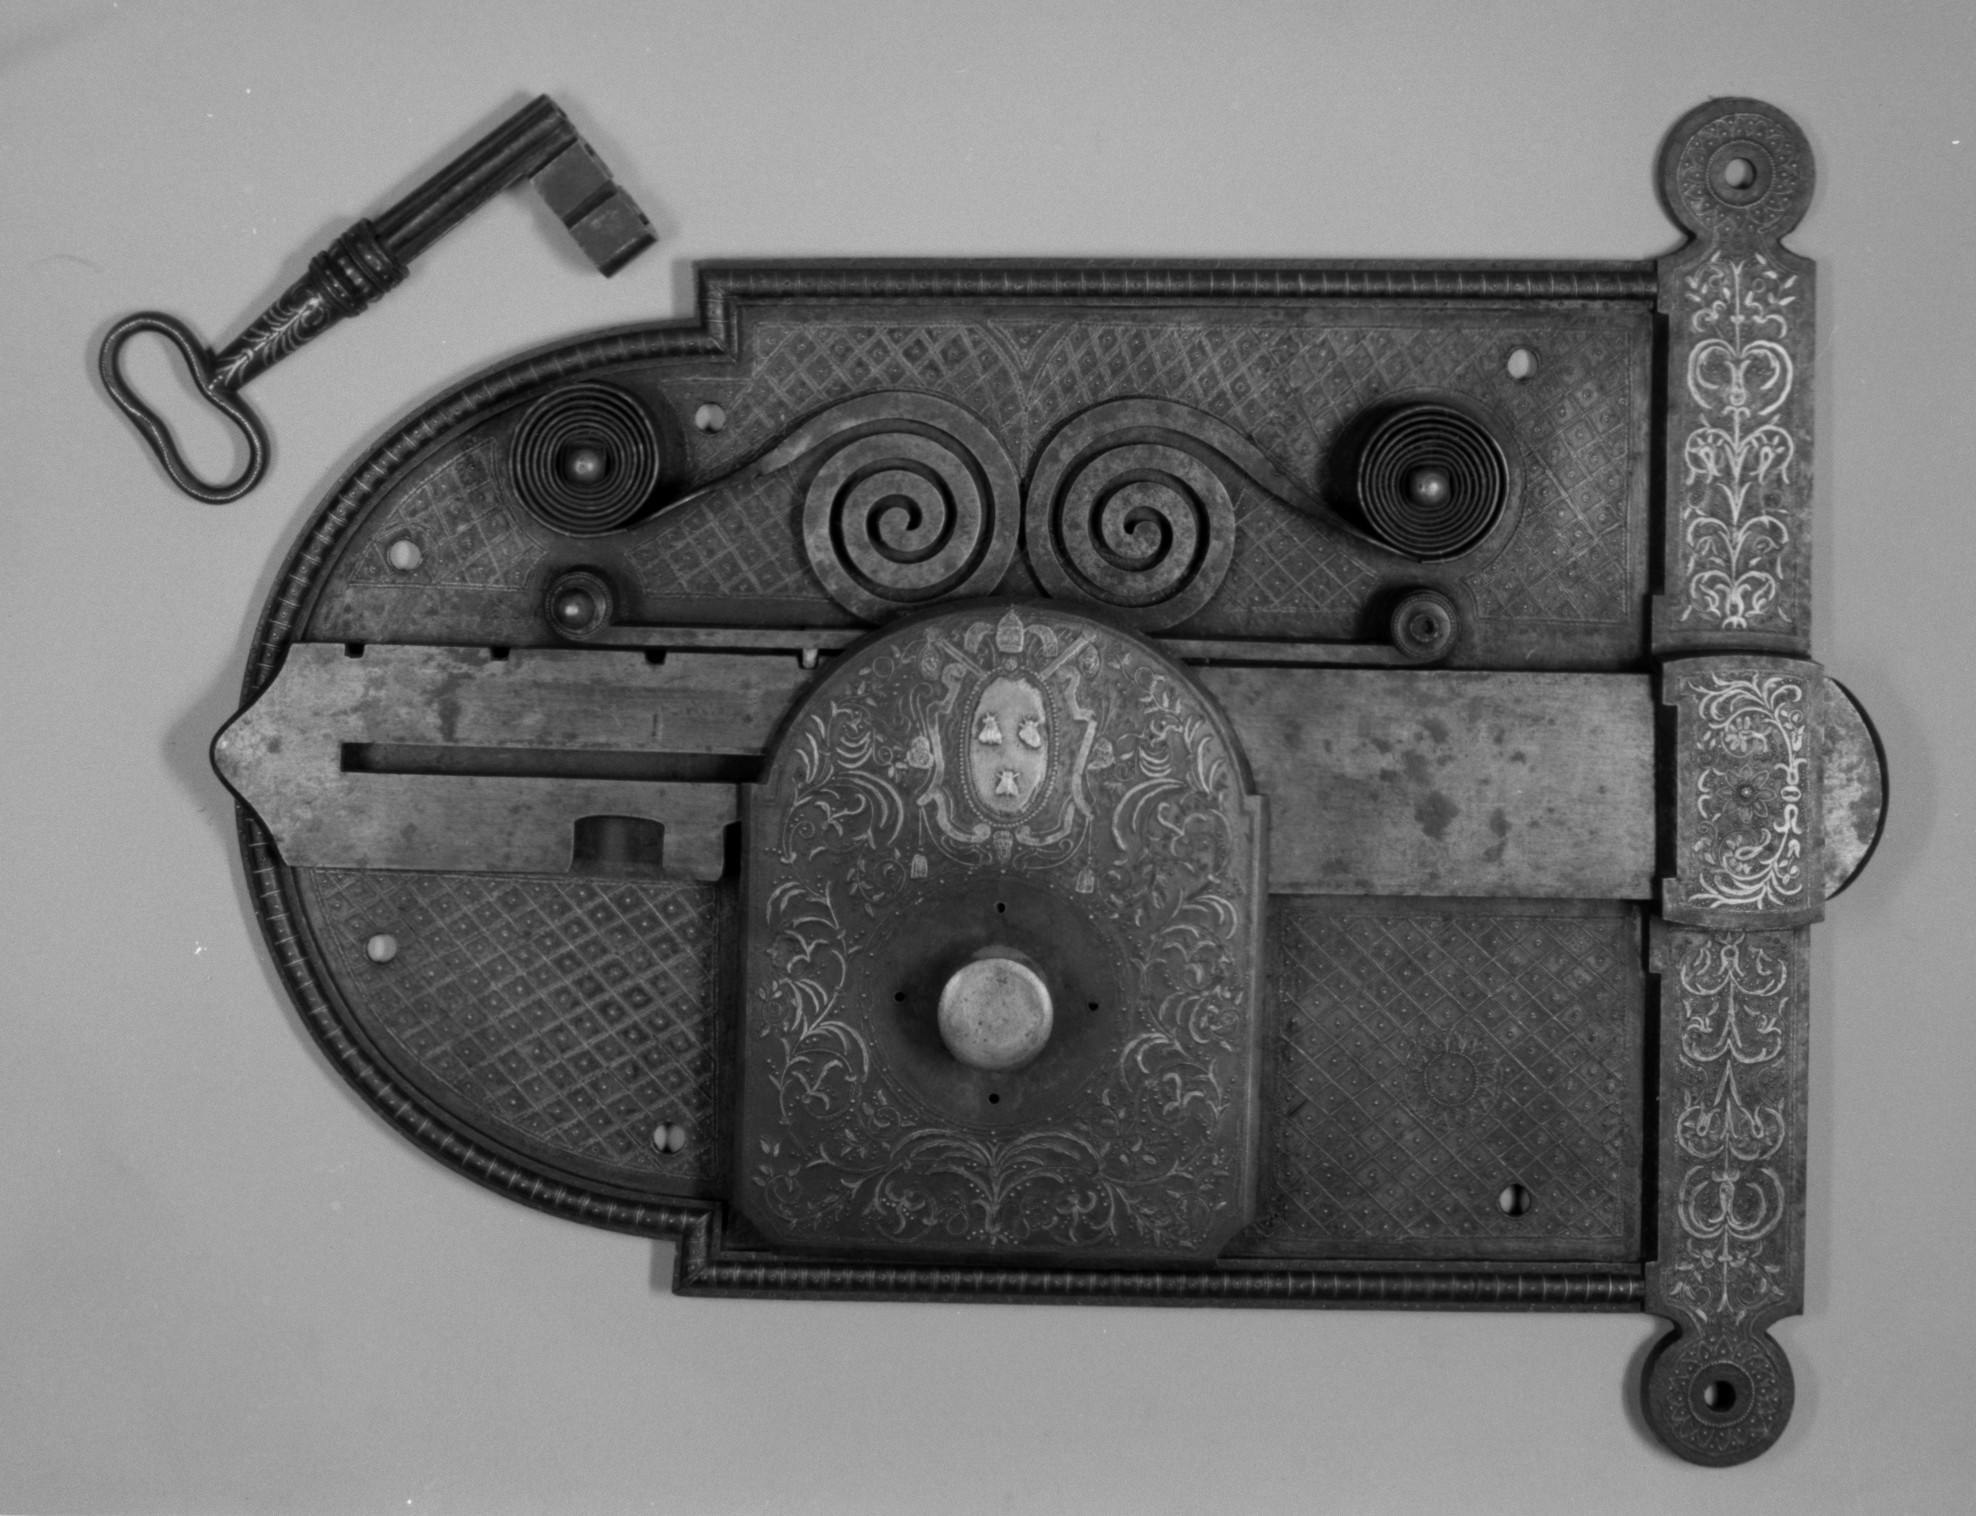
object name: lock and key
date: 1601-1700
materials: iron, silver